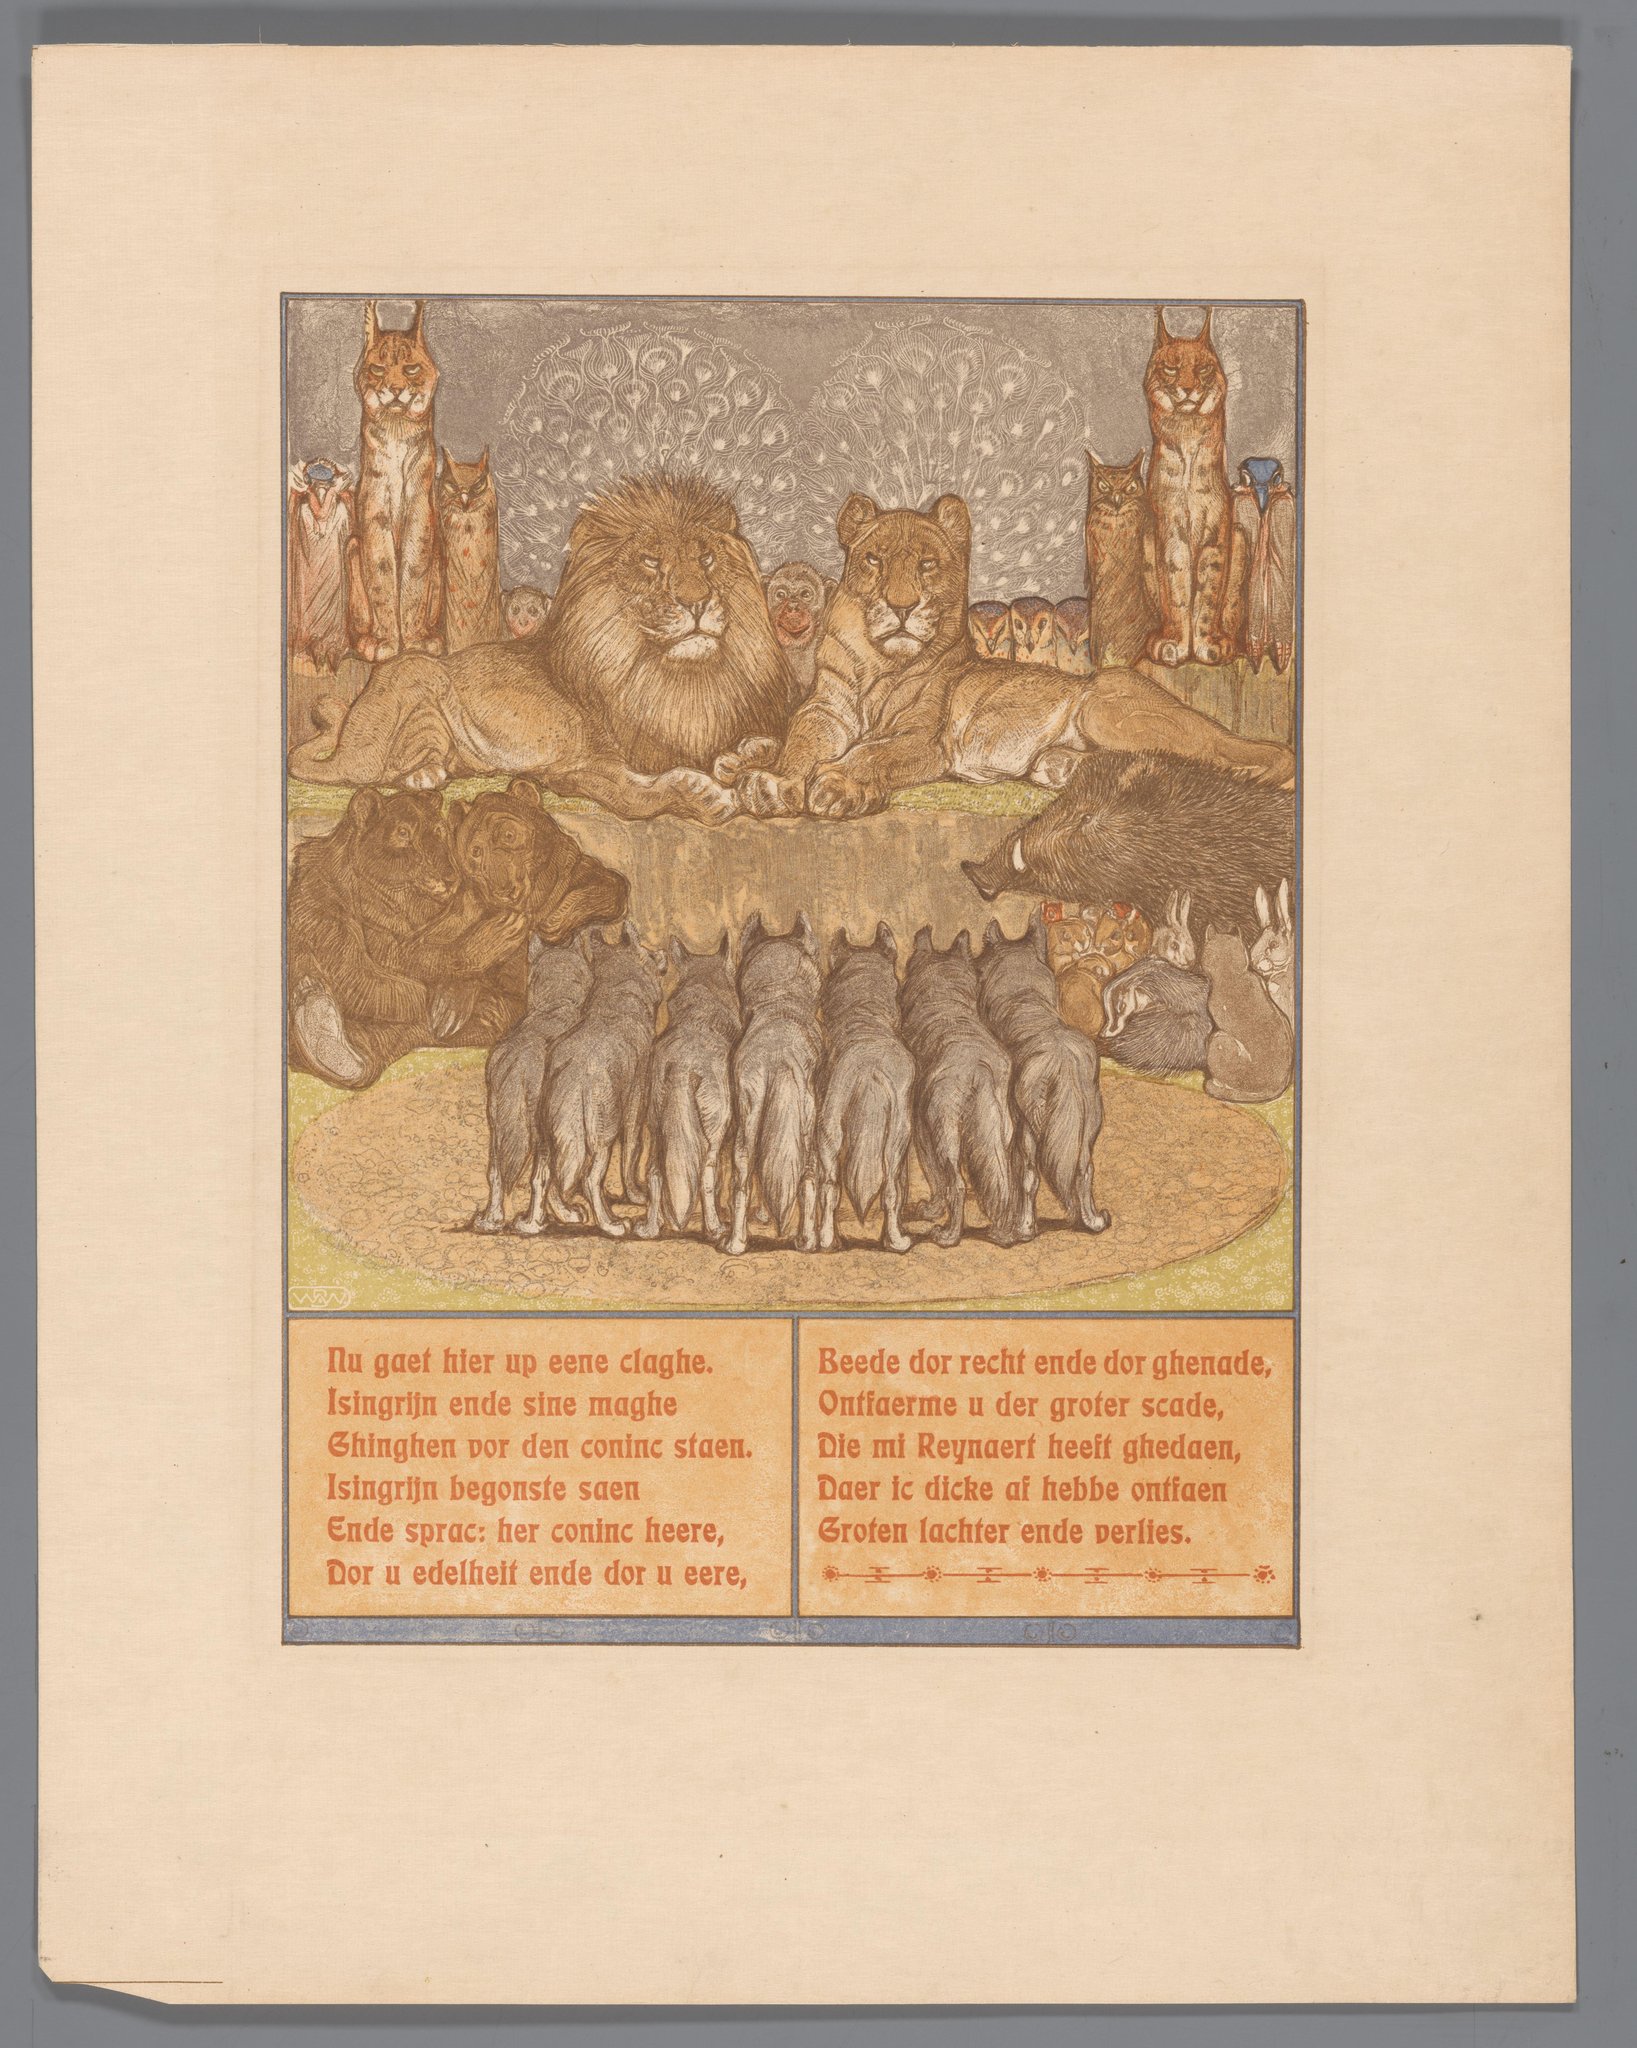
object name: book illustration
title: Groep wolven voor een liggende leeuw (Nobel) en leeuwin (Gentel)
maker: bernard willem wierink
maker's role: draughtsman, print maker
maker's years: 1856-1939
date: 1910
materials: paper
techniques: lithograph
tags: fable of reynard the fox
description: Prent gebruikt in: Streuvels, Stijn (Frank Lateur). Reinaert de Vos naar verschillende uitgaven van het middeleeuwsche epos. Amsterdam: L.J. Veen, 1910.